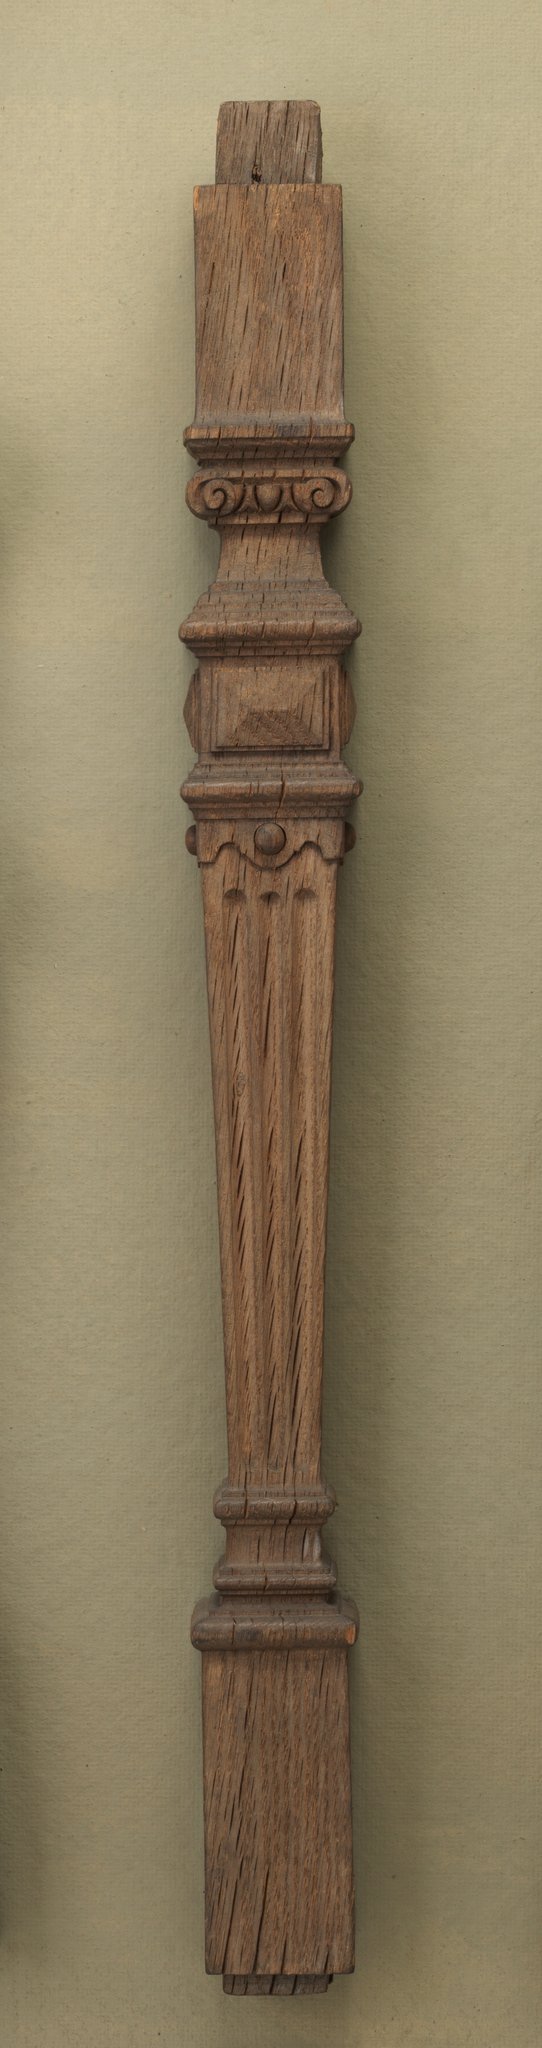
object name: baluster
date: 1601-1650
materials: wood